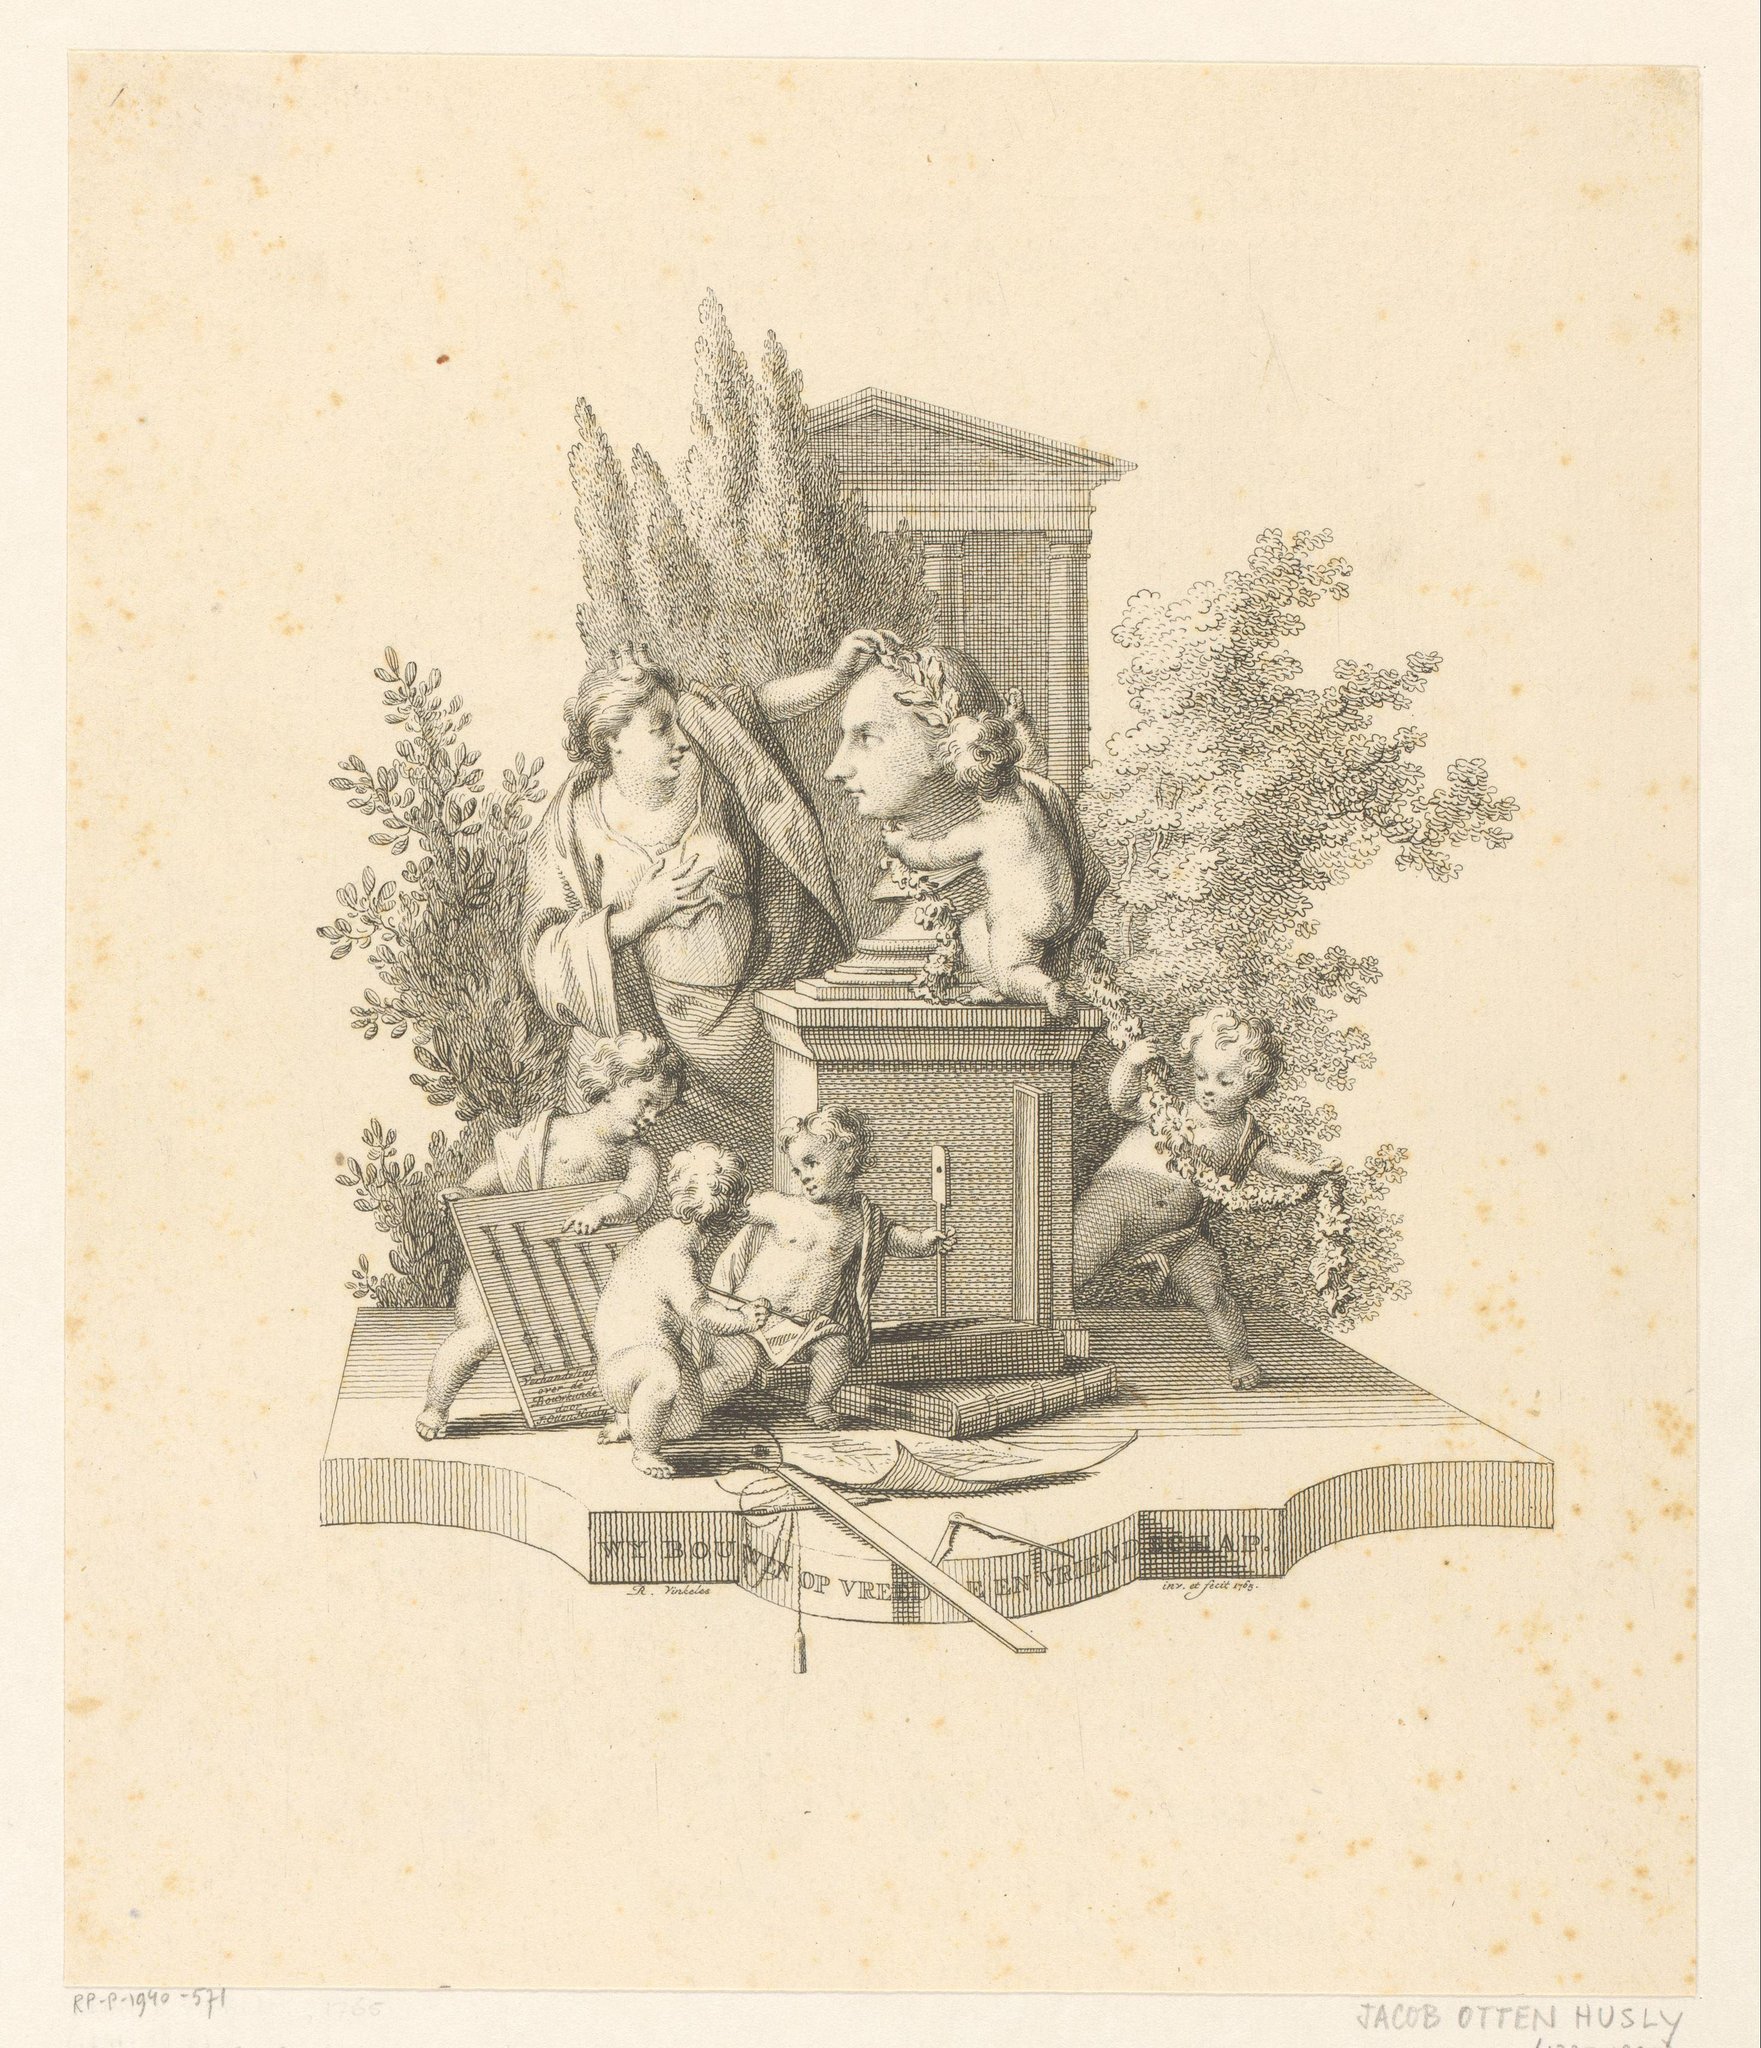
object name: print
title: Allegorische voorstelling met een buste van Jacob Otten Huslij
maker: reinier vinkeles (i)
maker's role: draughtsman, print maker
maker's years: 1741-1816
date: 1765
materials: paper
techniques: etching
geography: amsterdam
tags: draughtsman, jacob otten huslij, tools, implements of draughtsman, ornament ~ festoon, garland, cupids: 'amores', 'amoretti', 'putti'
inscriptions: collector's mark: Lugt 2760, collector's mark: Lugt 2228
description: Allegorische voorstelling met een buste van de tekenaar Jacob Otten Huslij. De buste wordt gelauwerd door putti en een vrouwenfiguur met torens van een burcht op haar hoofd. Op de voorgrond tekenattributen zoals liniaal, passer en tekenvellen.